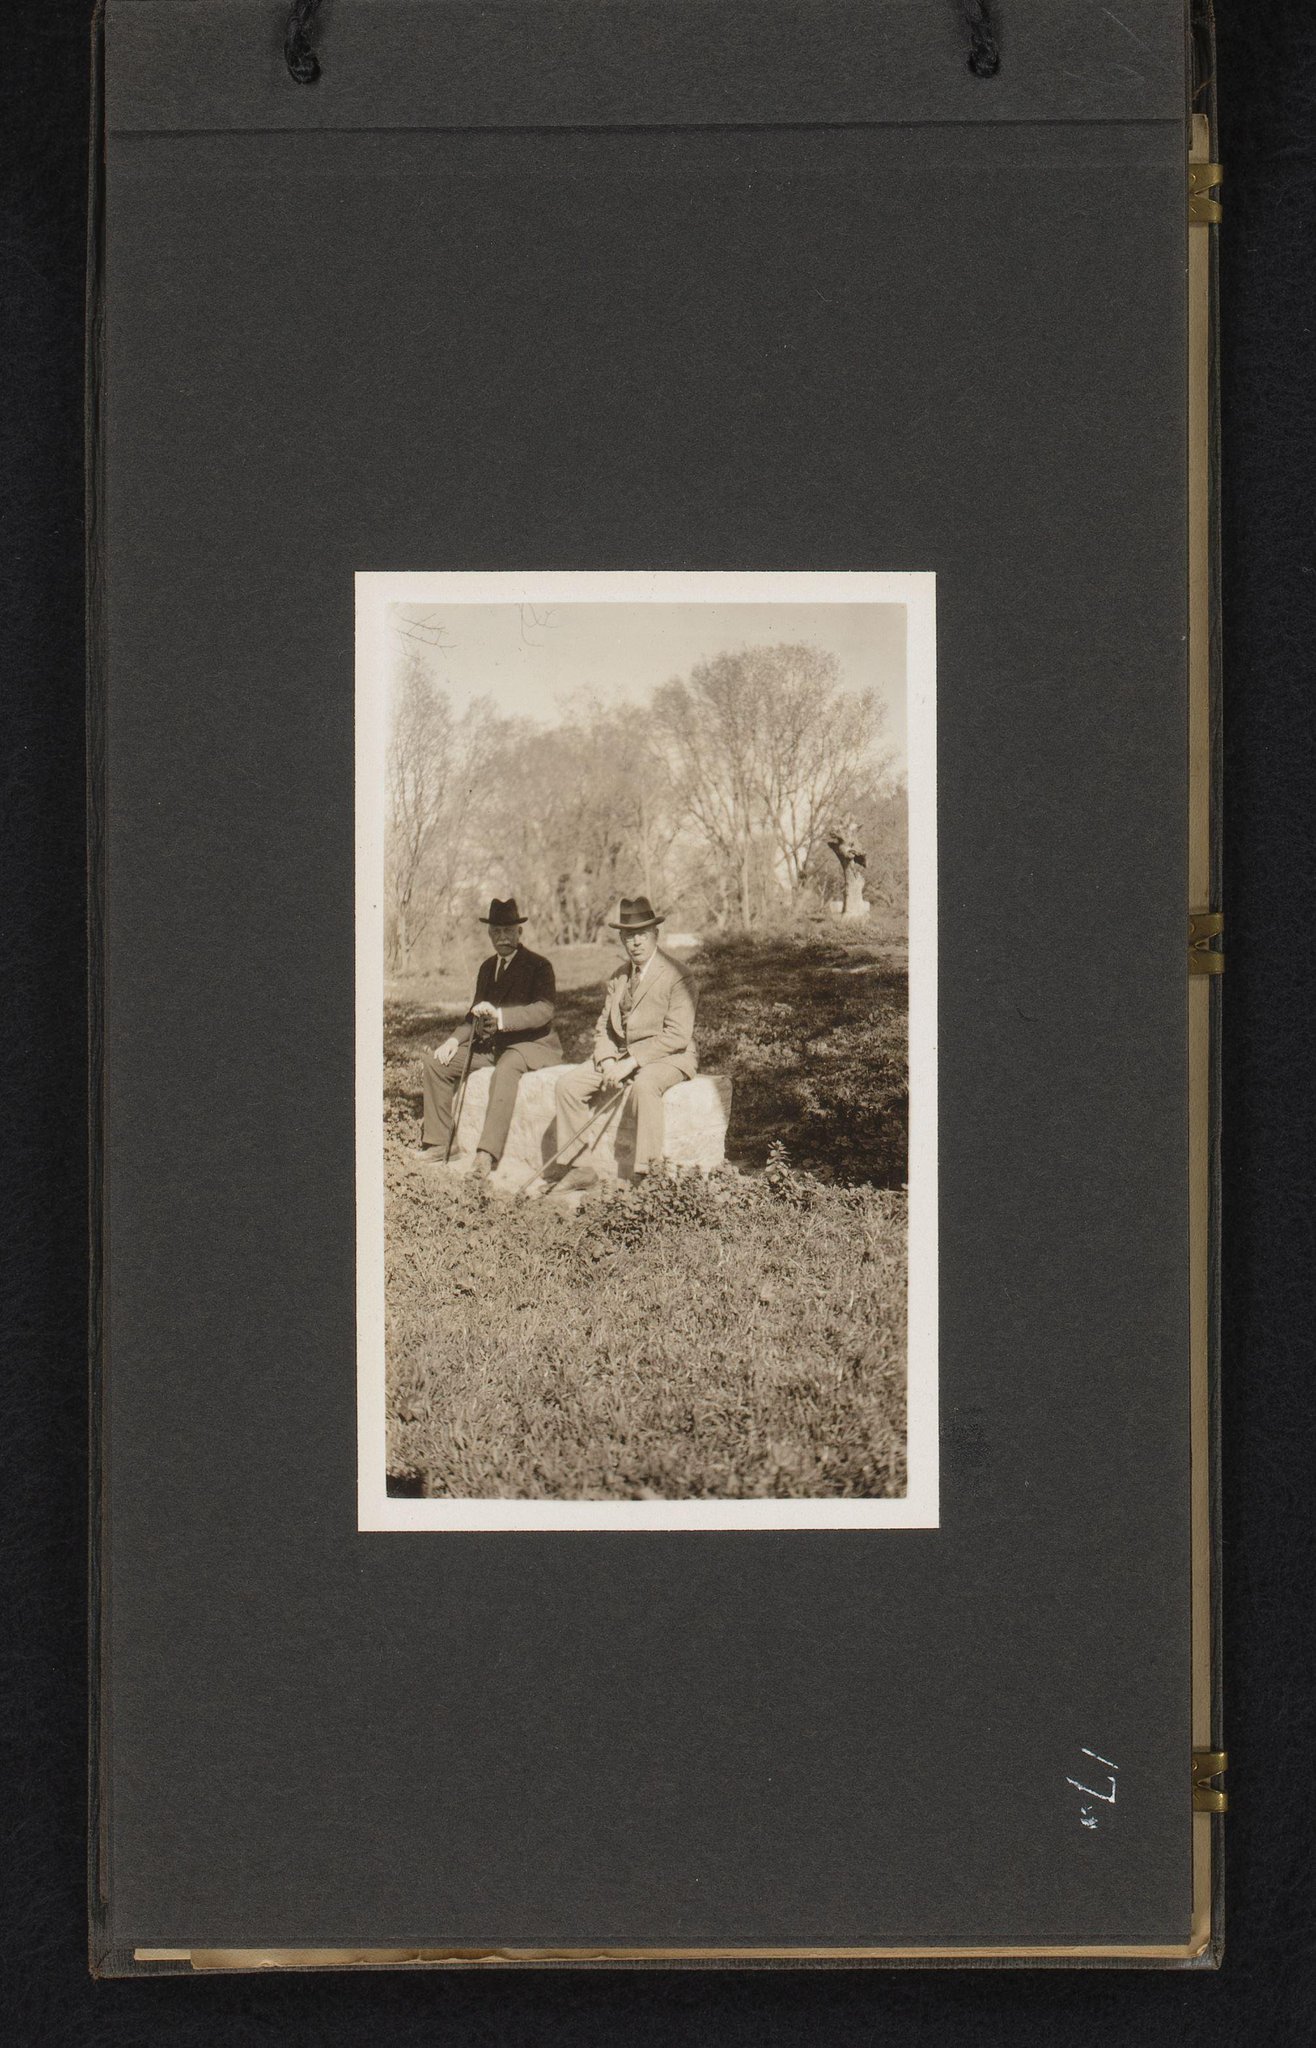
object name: photograph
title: Twee Europese mannen zittend in het Bois Sacré te Tlemcen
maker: a.g.a. van eelde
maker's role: engineer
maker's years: 1862-1950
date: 1927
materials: paper, photographic support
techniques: gelatin silver print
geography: tlemcen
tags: adult man, historical persons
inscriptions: number: ‘17.’